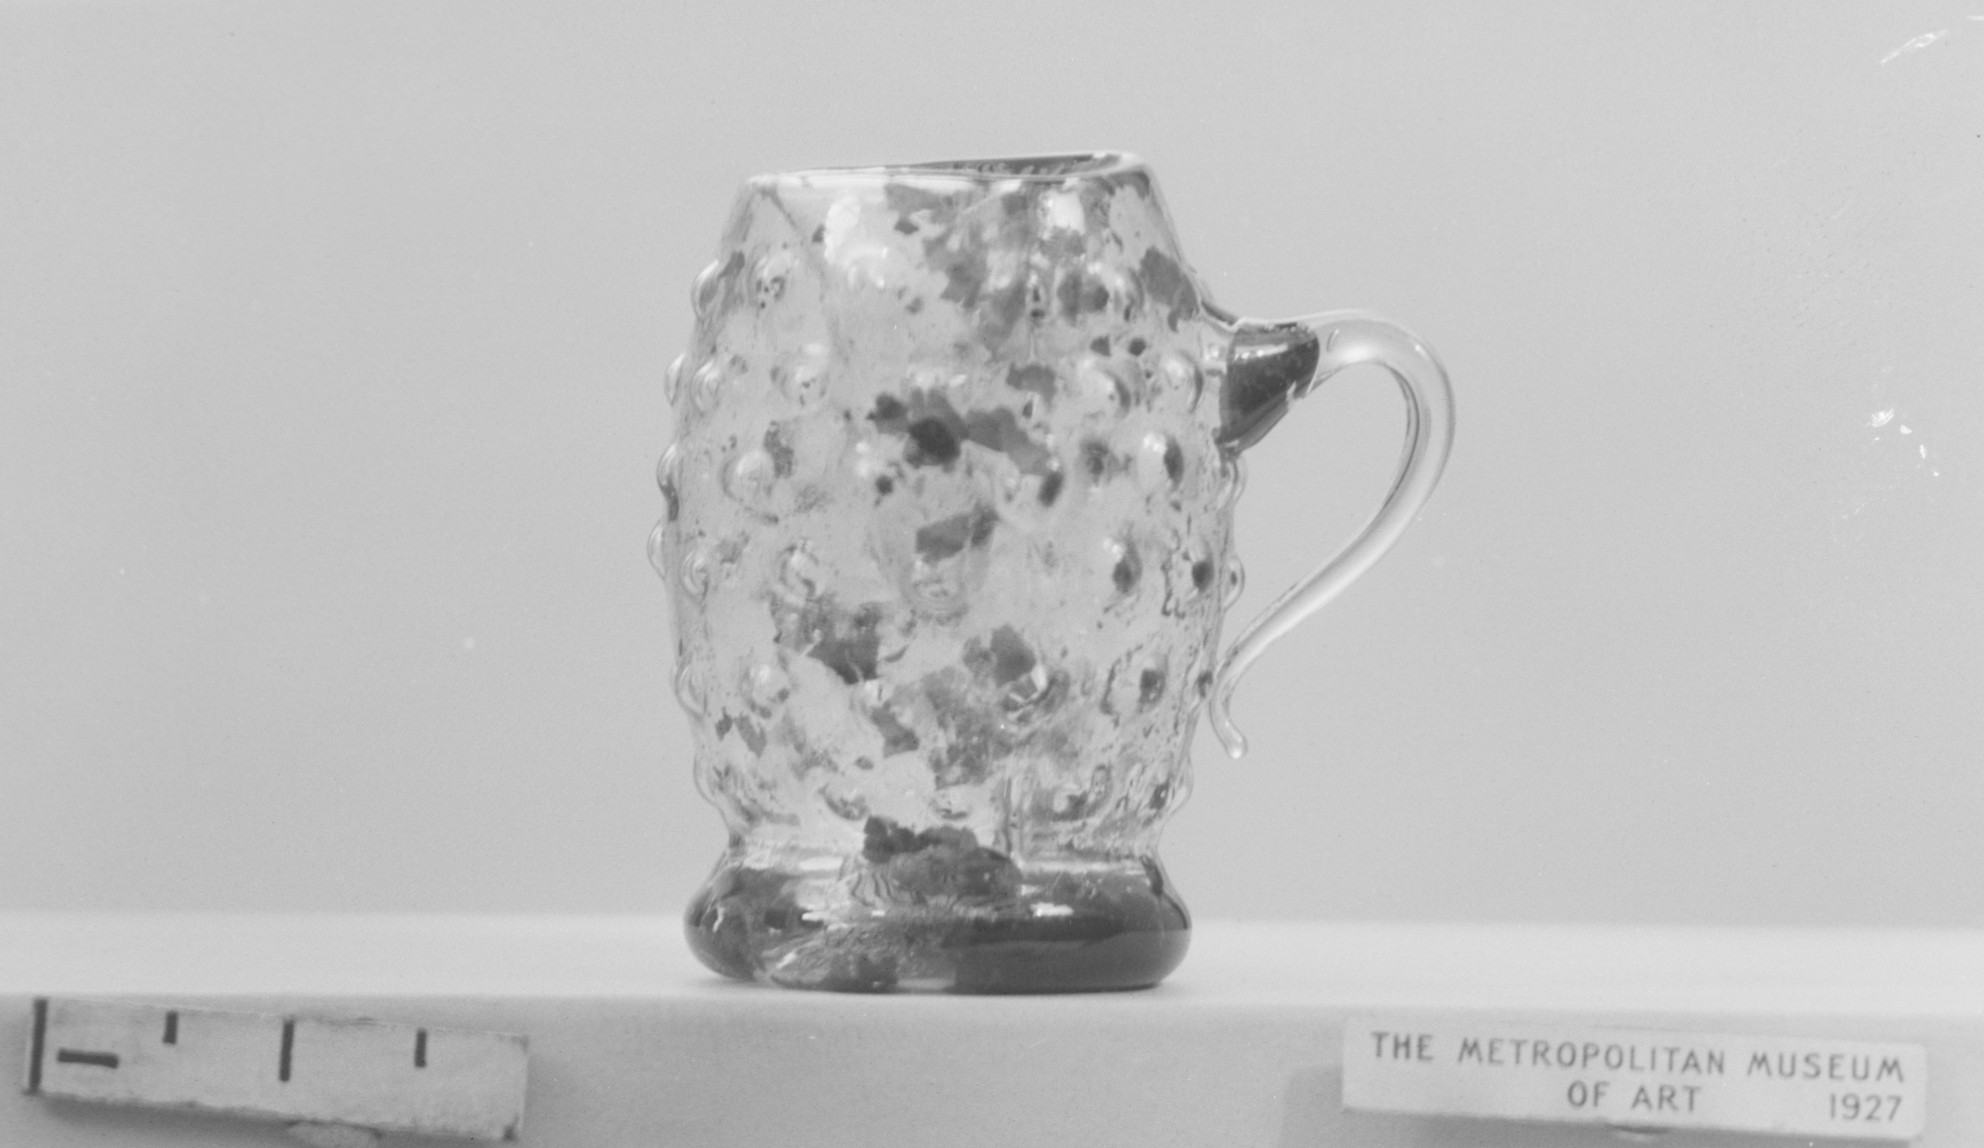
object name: mug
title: Miniature mug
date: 1801-1833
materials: glass